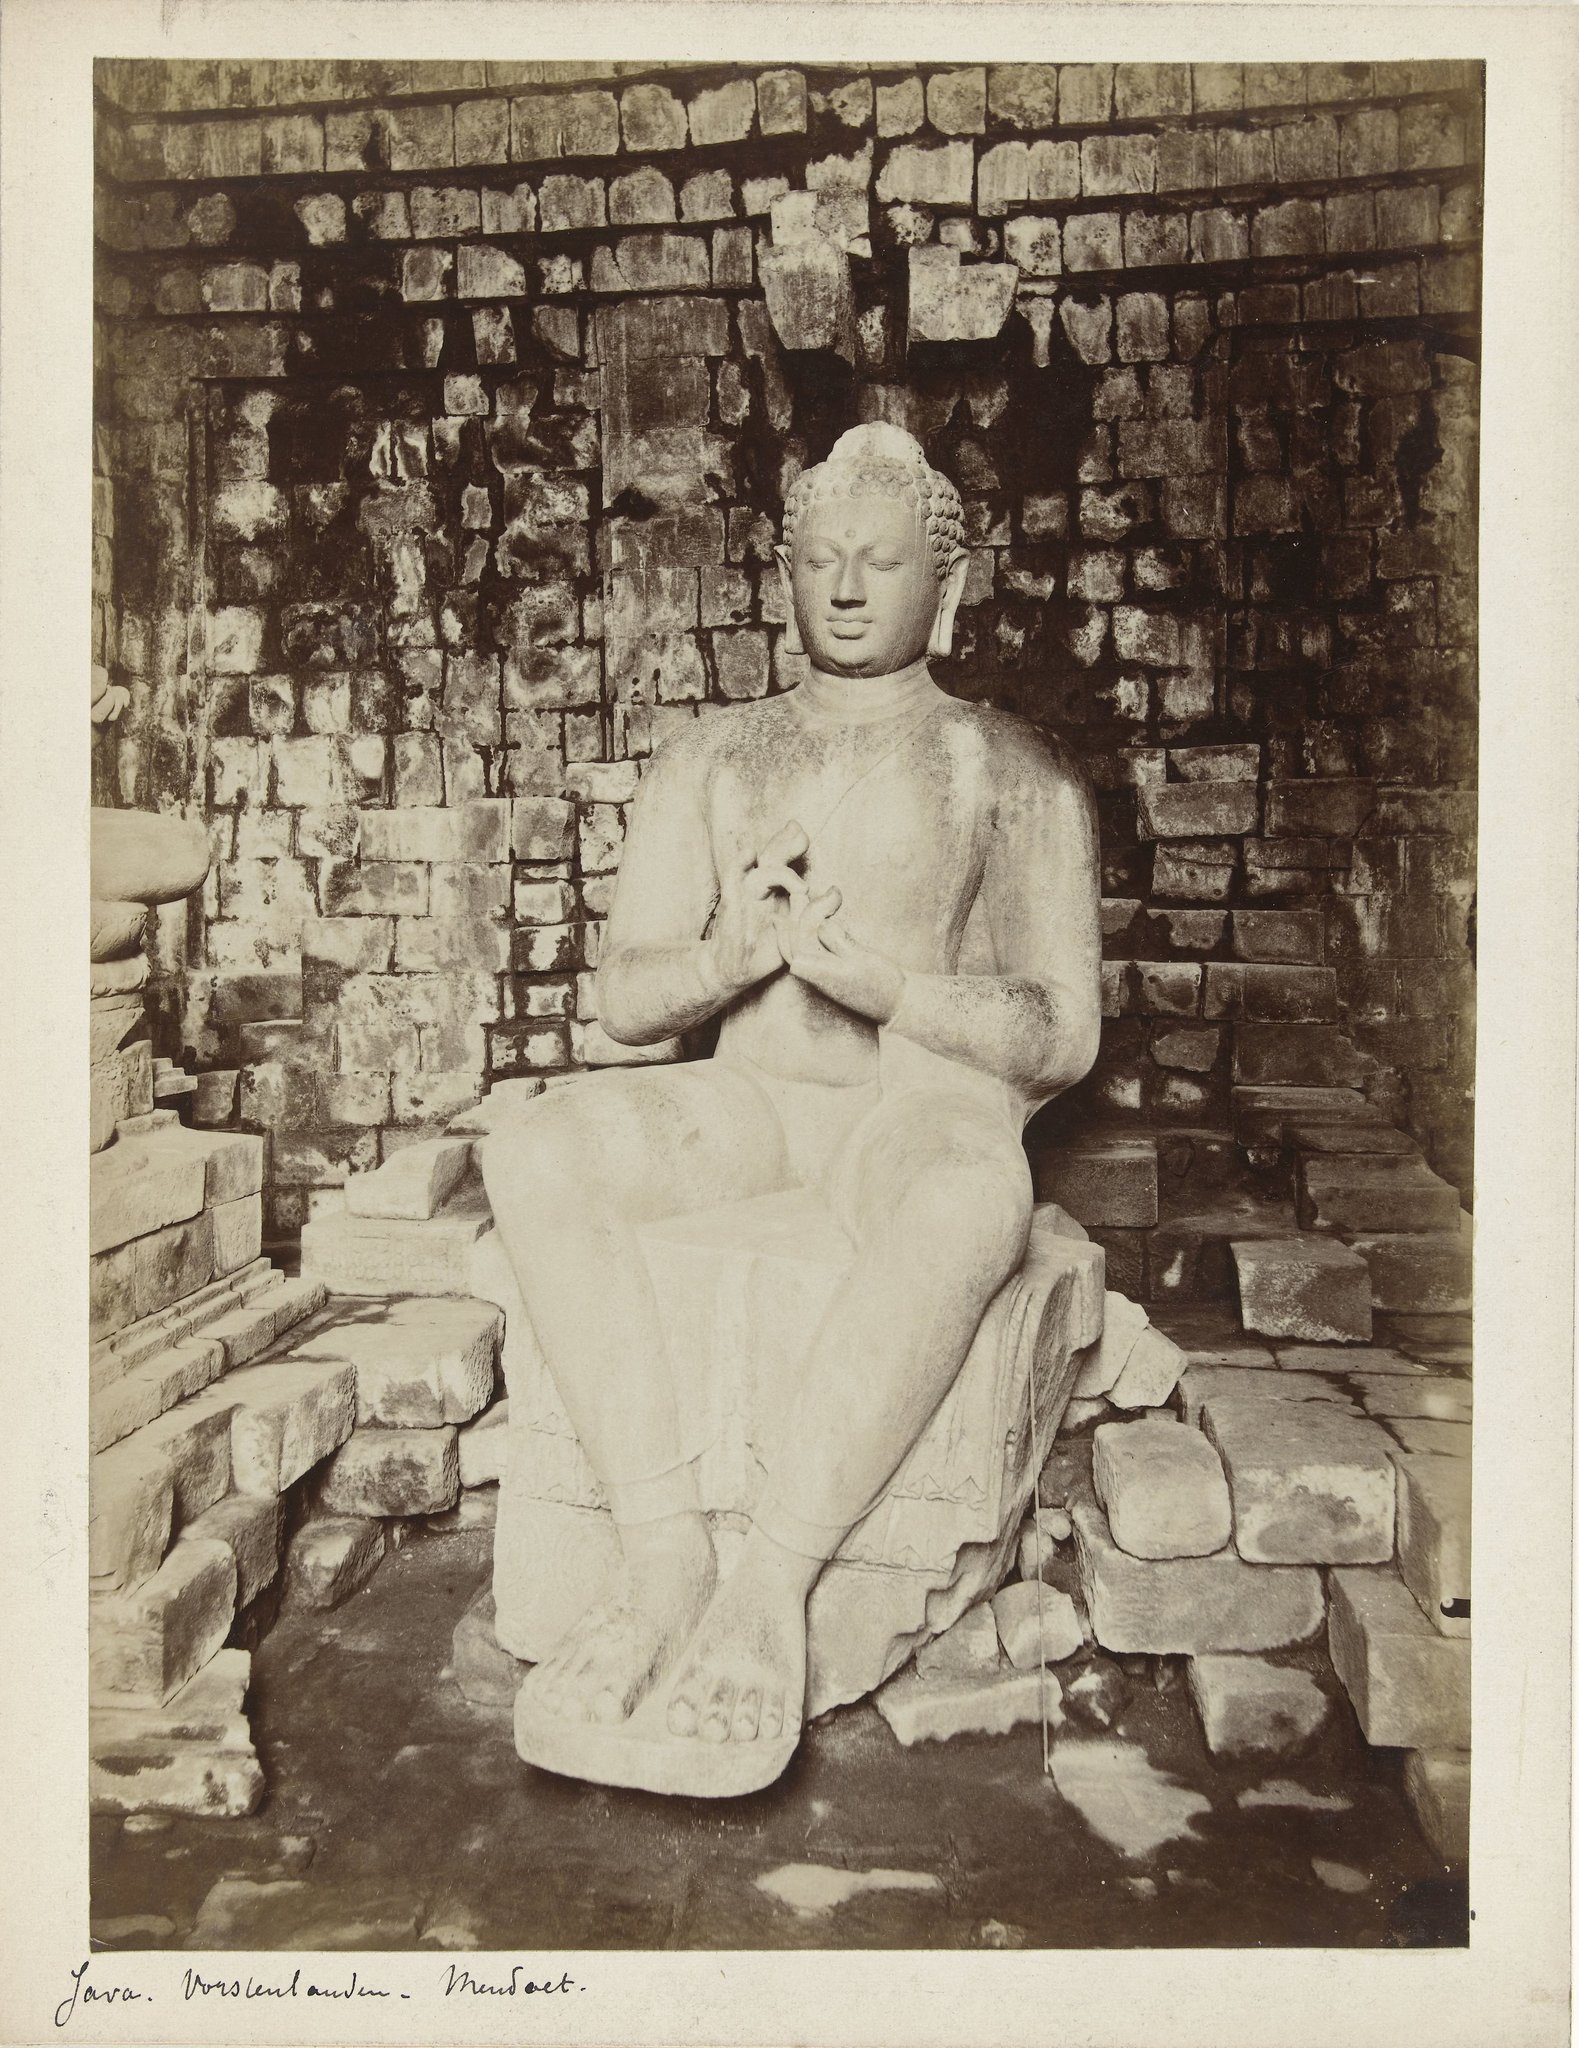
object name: photograph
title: Java. Voerstenlanden - Mendoet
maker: kassian céphas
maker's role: fotograaf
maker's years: 1845-1912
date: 1890-1900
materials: cardboard, paper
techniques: albumen print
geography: magelang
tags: temple, shrine ~ hinduism, buddhism, jainism, monument, statue, buddha, founder of buddhism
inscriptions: inscription: ‘Java. Vorstenlanden - Mendoet’, number: ‘55’